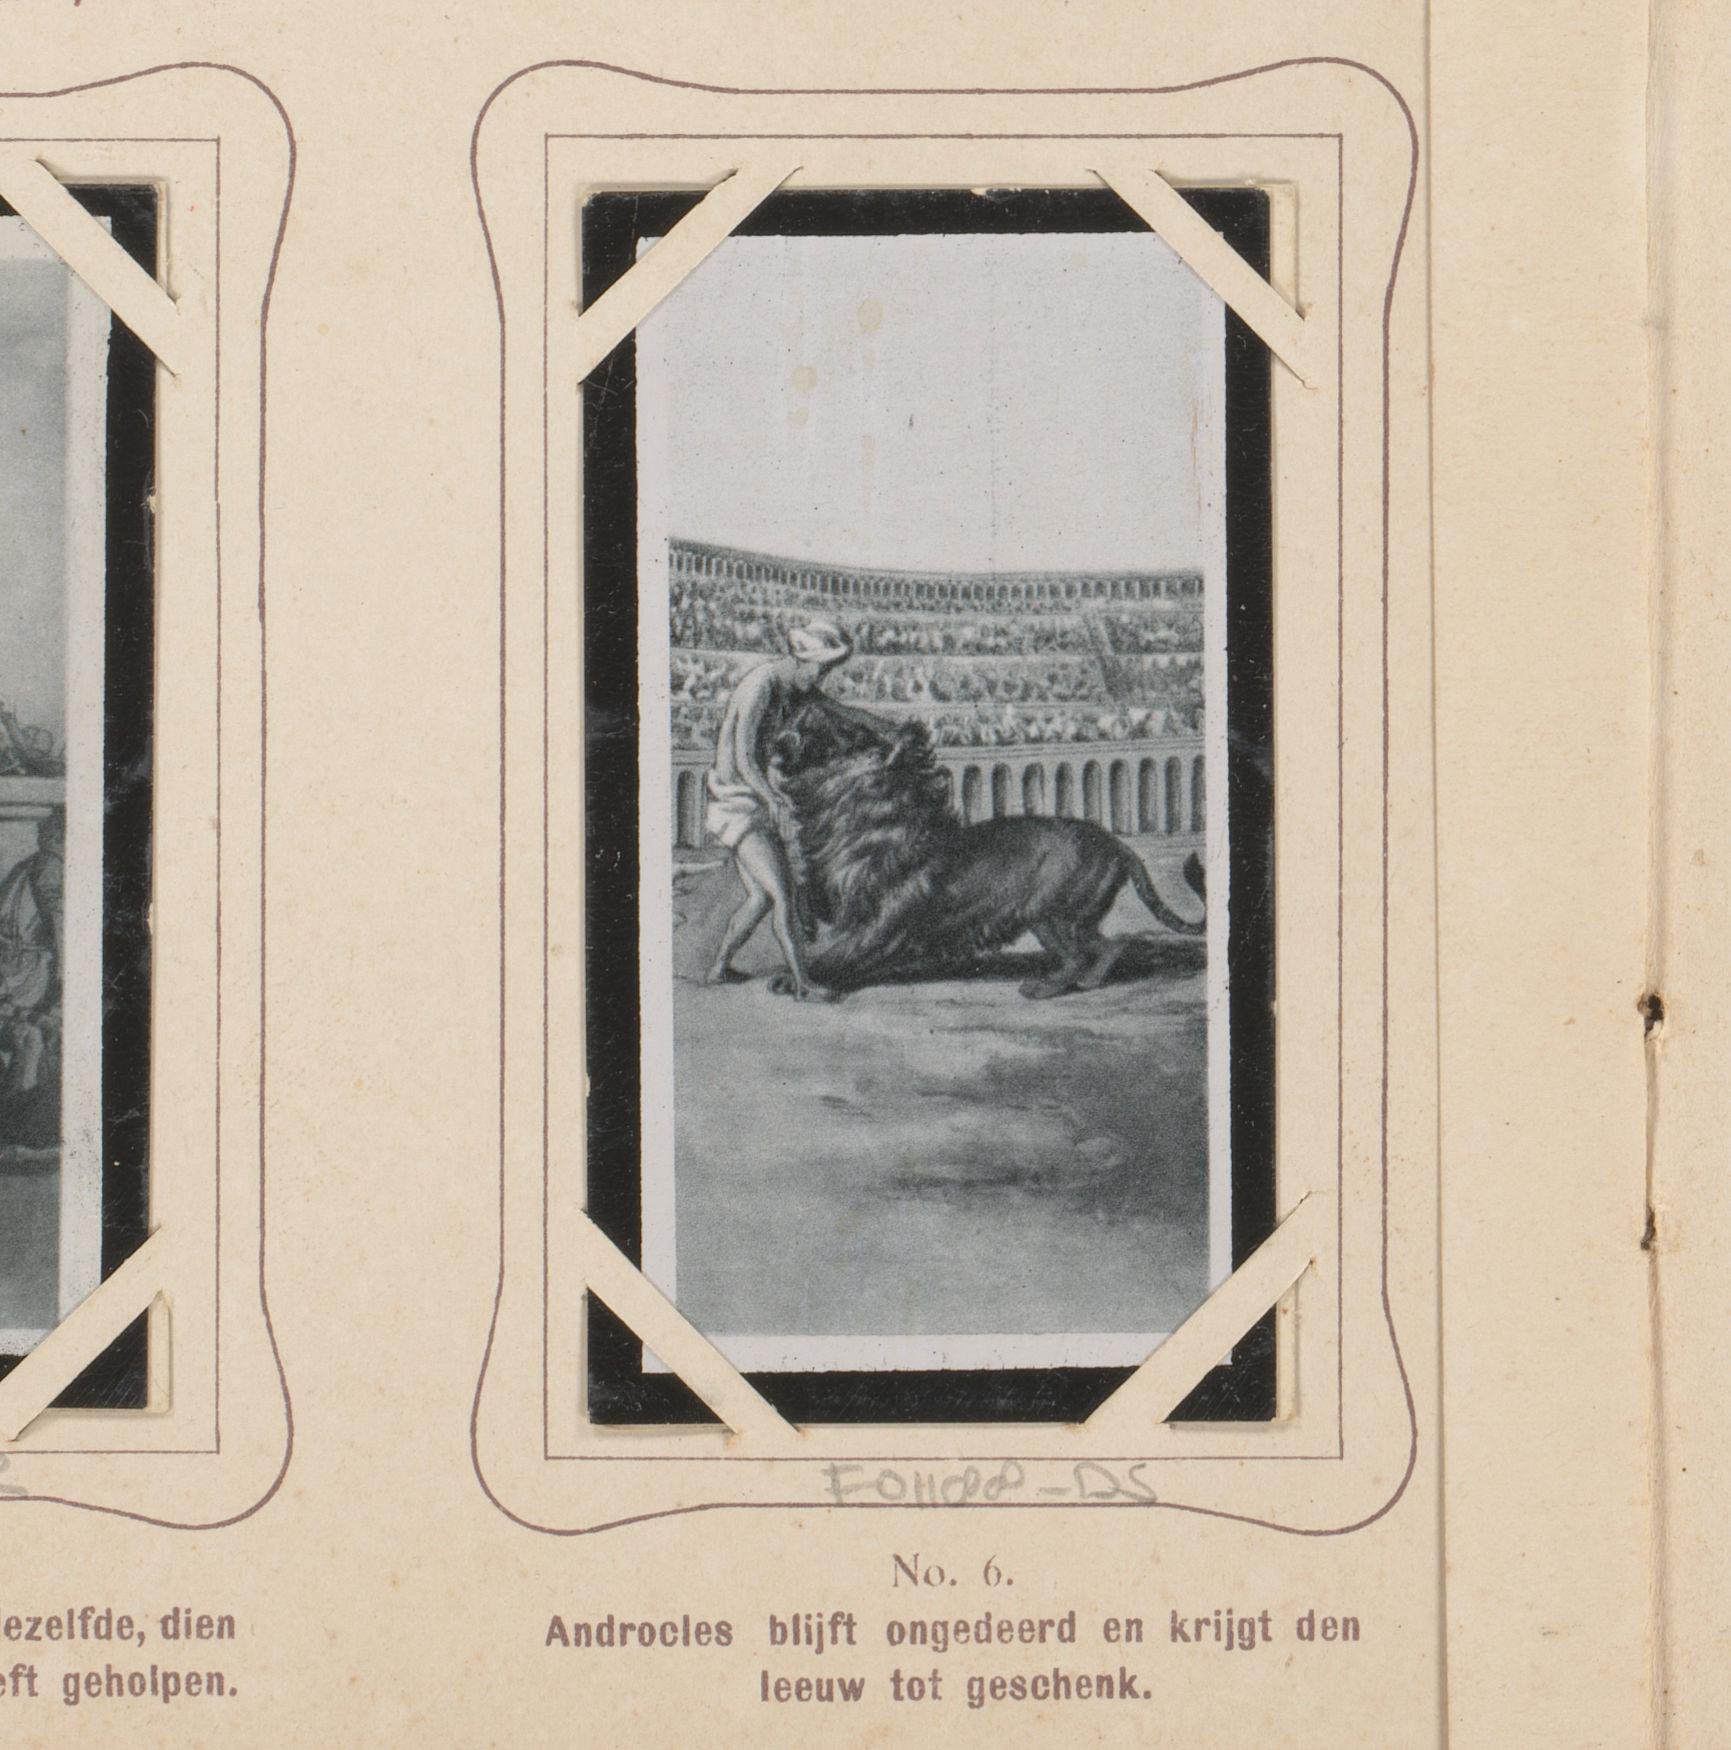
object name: reproduction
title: Reproductie van een tekening met Androclus en de leeuw, herenigd in het Colosseum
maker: Anonymous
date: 1906-1907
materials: paper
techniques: photograph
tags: (story of) androclus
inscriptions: inscription: ‘No. 6./ Androcles blijft ongedeerd en krijgt den leeuw tot geschenk.’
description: Deze prent maakt deel uit van een album.